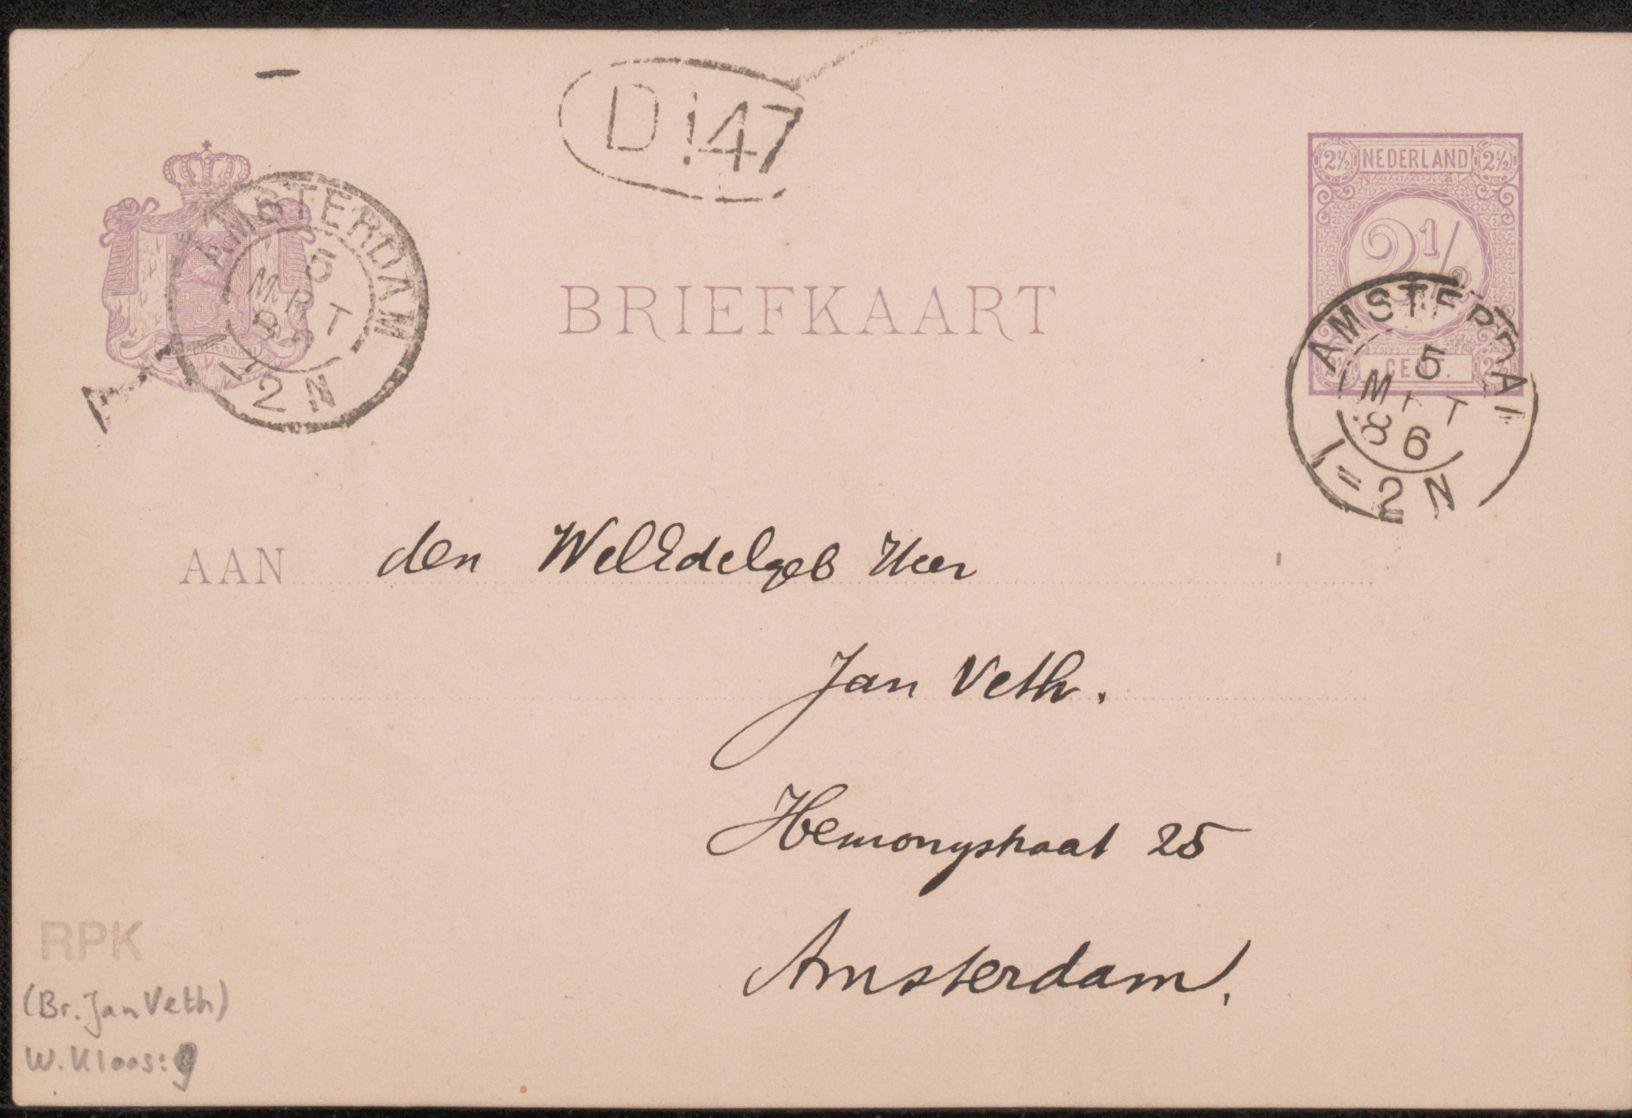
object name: postcard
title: Briefkaart aan Jan Veth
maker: willem kloos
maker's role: dichter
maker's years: 1859-1938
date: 1886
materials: cardboard, ink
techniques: pen, writing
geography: amsterdam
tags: painter, draughtsman, designer, jan veth, carel vosmaer, jacques perk, historical persons (portraits and scenes from the life)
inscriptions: collector's mark: ‘RPK’